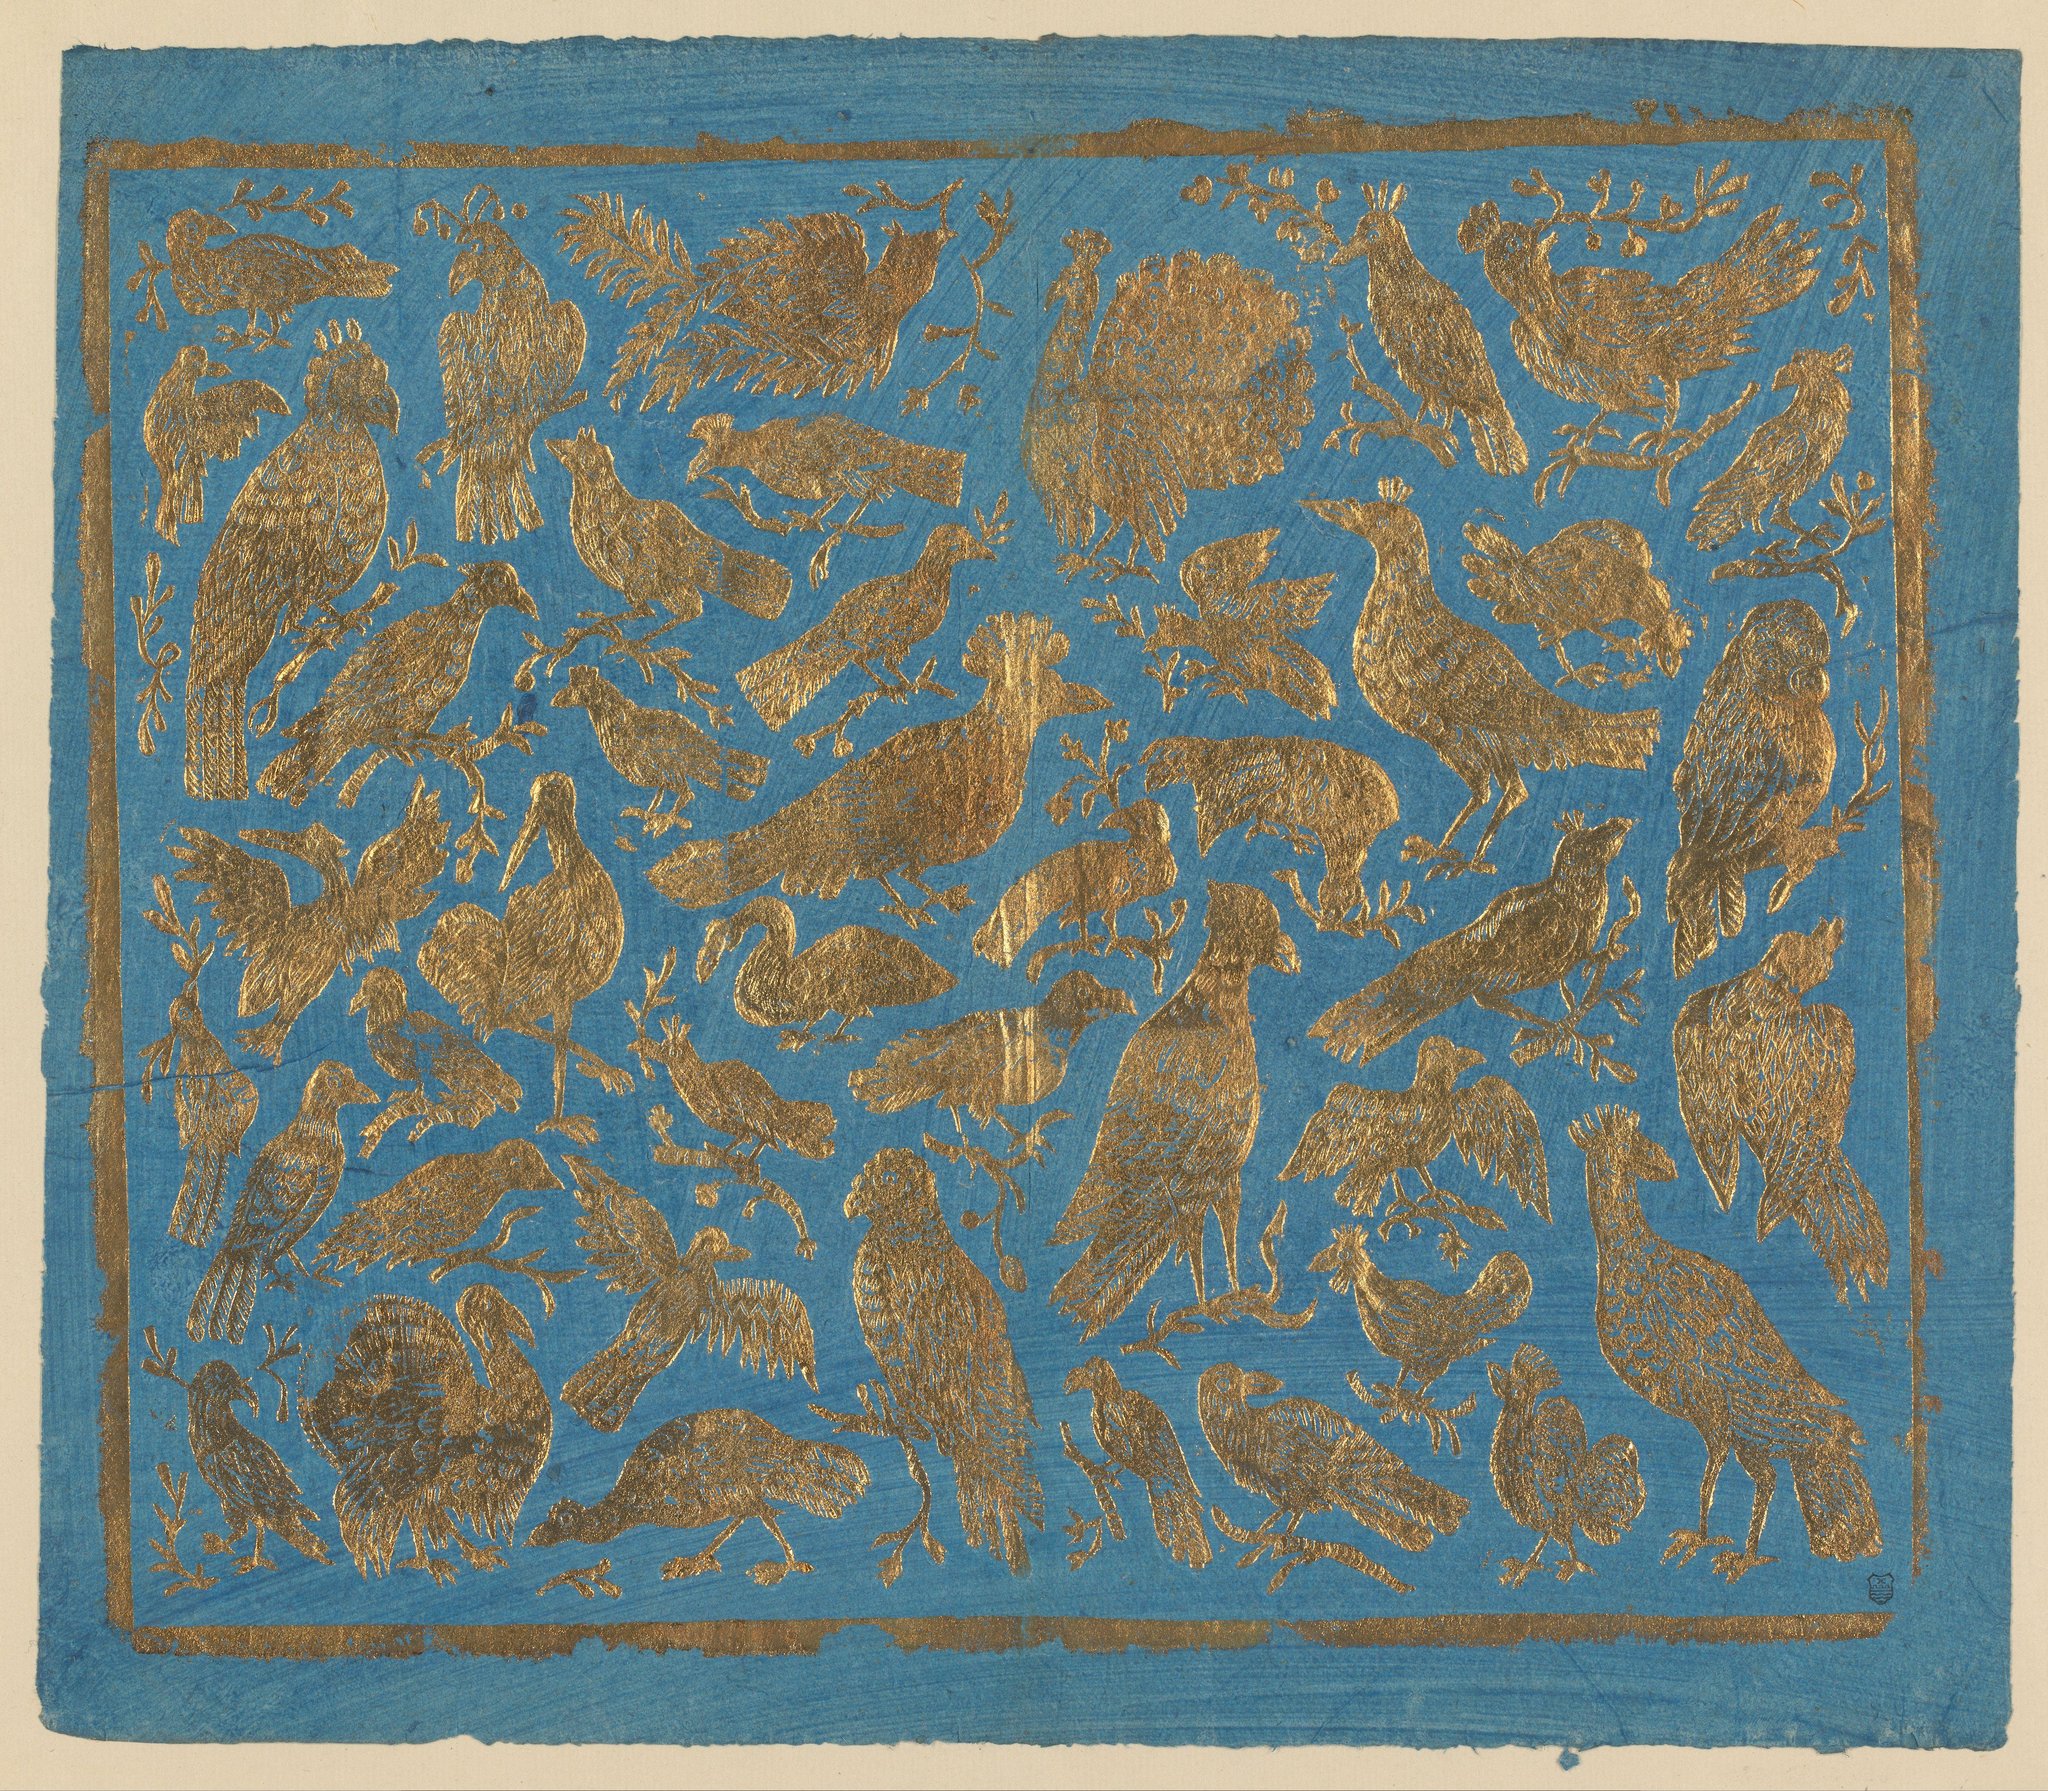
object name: brocade paper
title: Birds with Twigs and Fruits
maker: Anonymous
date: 1750-1800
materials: gold leaf, paint, paper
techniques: relief print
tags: birds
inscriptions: collector's mark: Lugt 2760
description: Blad met vogels met takjes en vruchtjes, linksonder een kalkoen